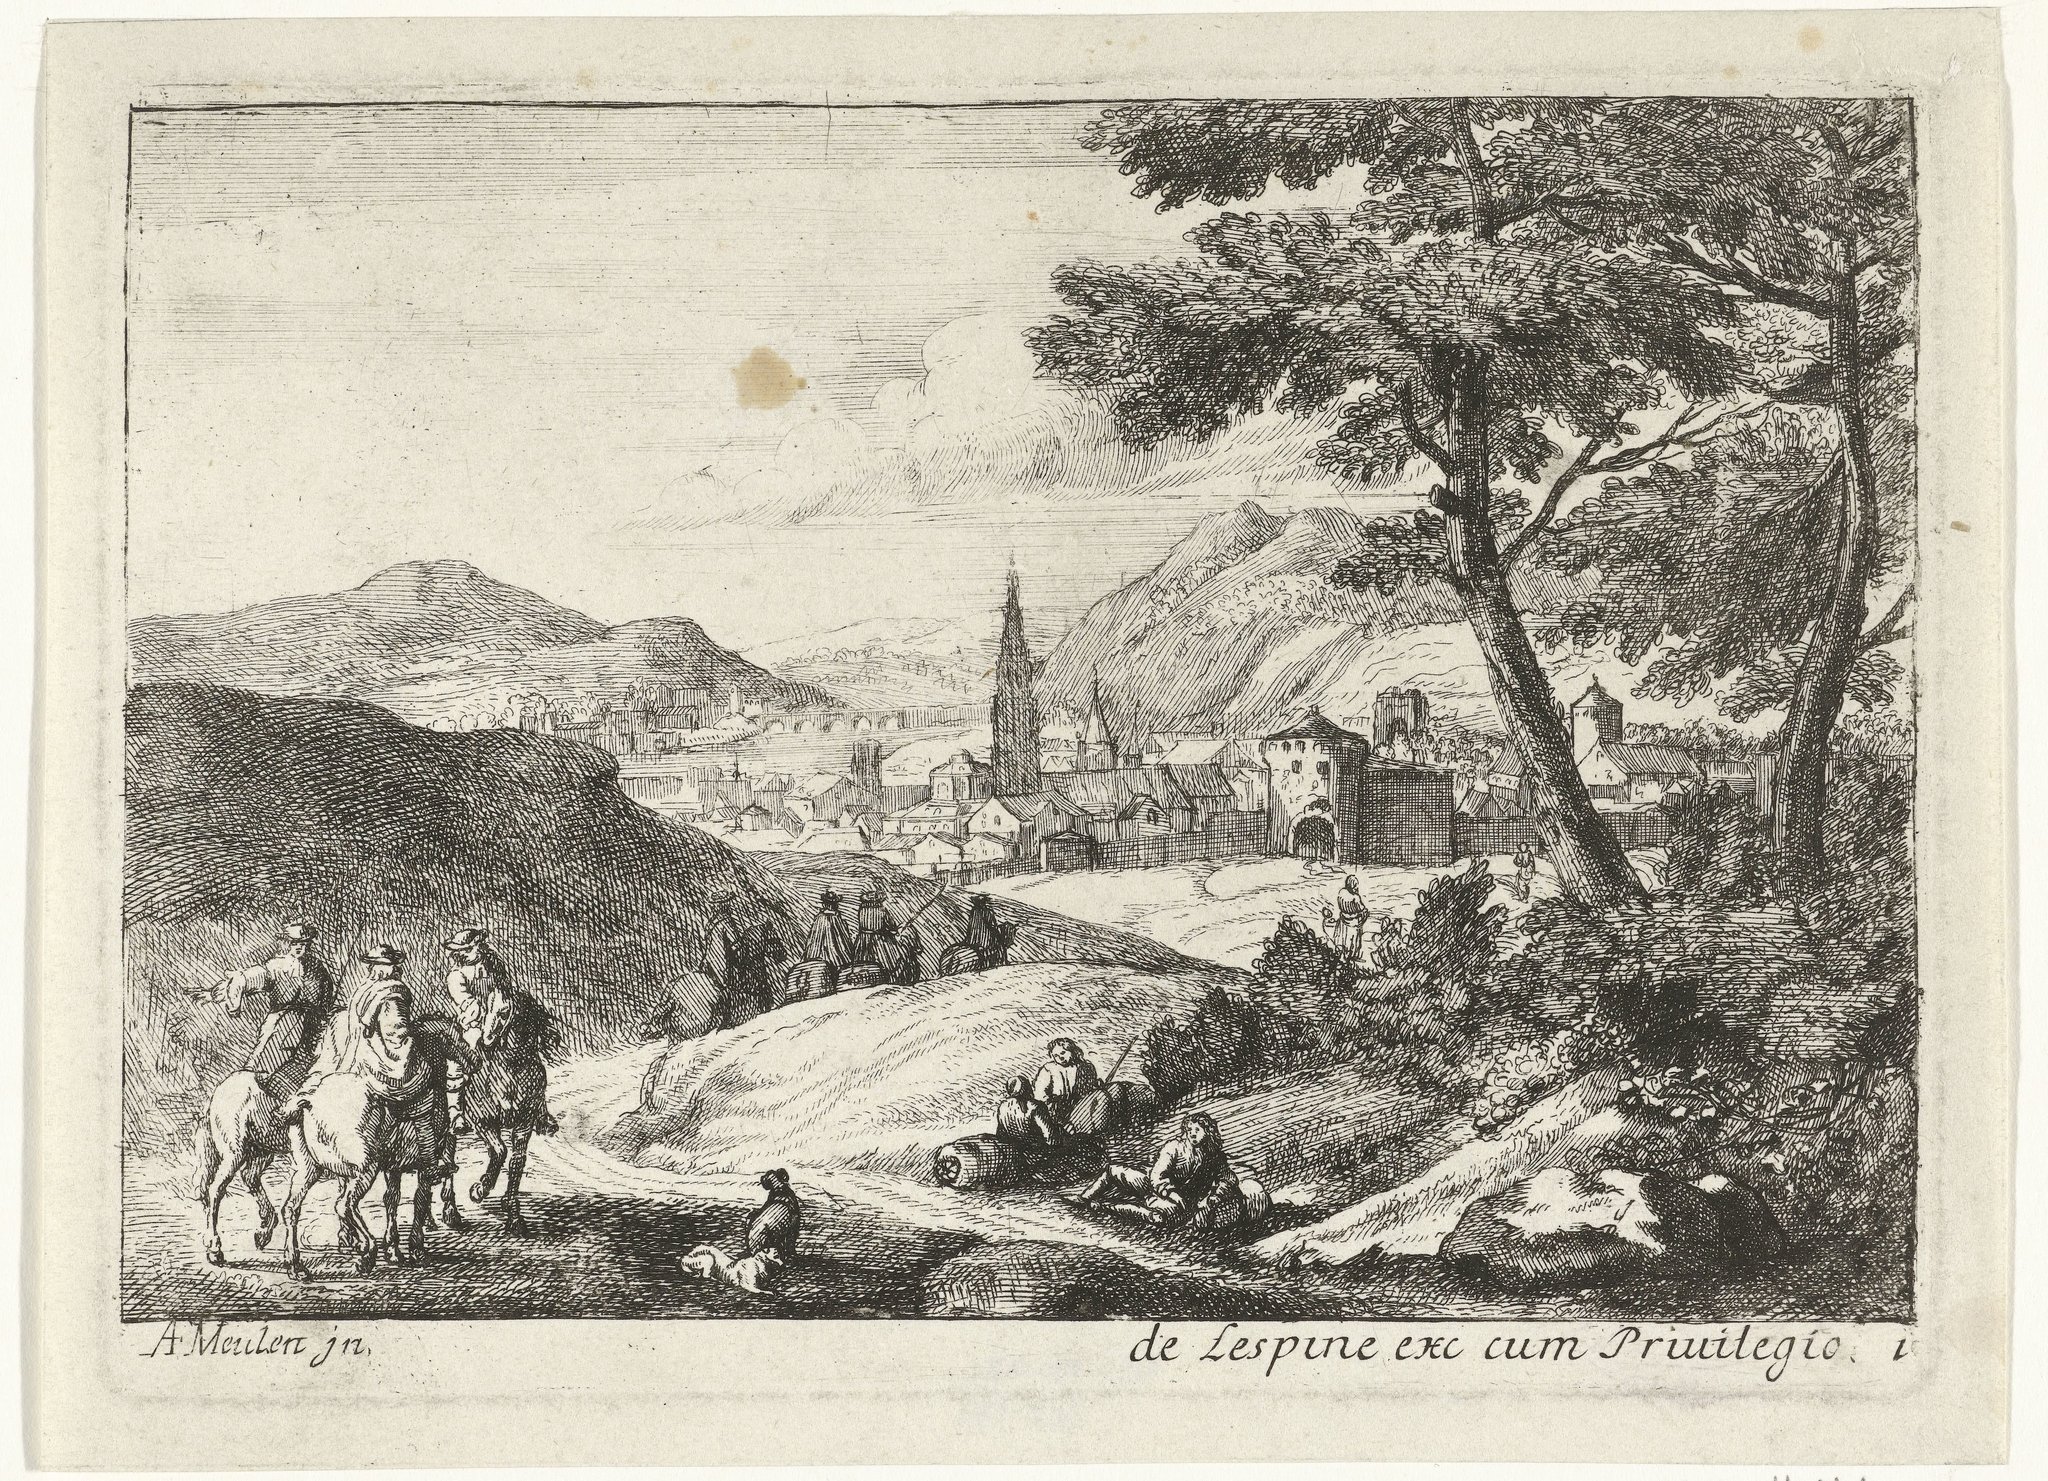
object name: print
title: Landschap met figuren en stad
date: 1675-1696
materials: paper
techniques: engraving, etching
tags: landscapes (+ landscape with figures, staffage)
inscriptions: collector's mark: Lugt 240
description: Heuvelachtig landschap met drie ruiters links en bossage rechts. In het midden op de achtergrond een stad met stadspoort.